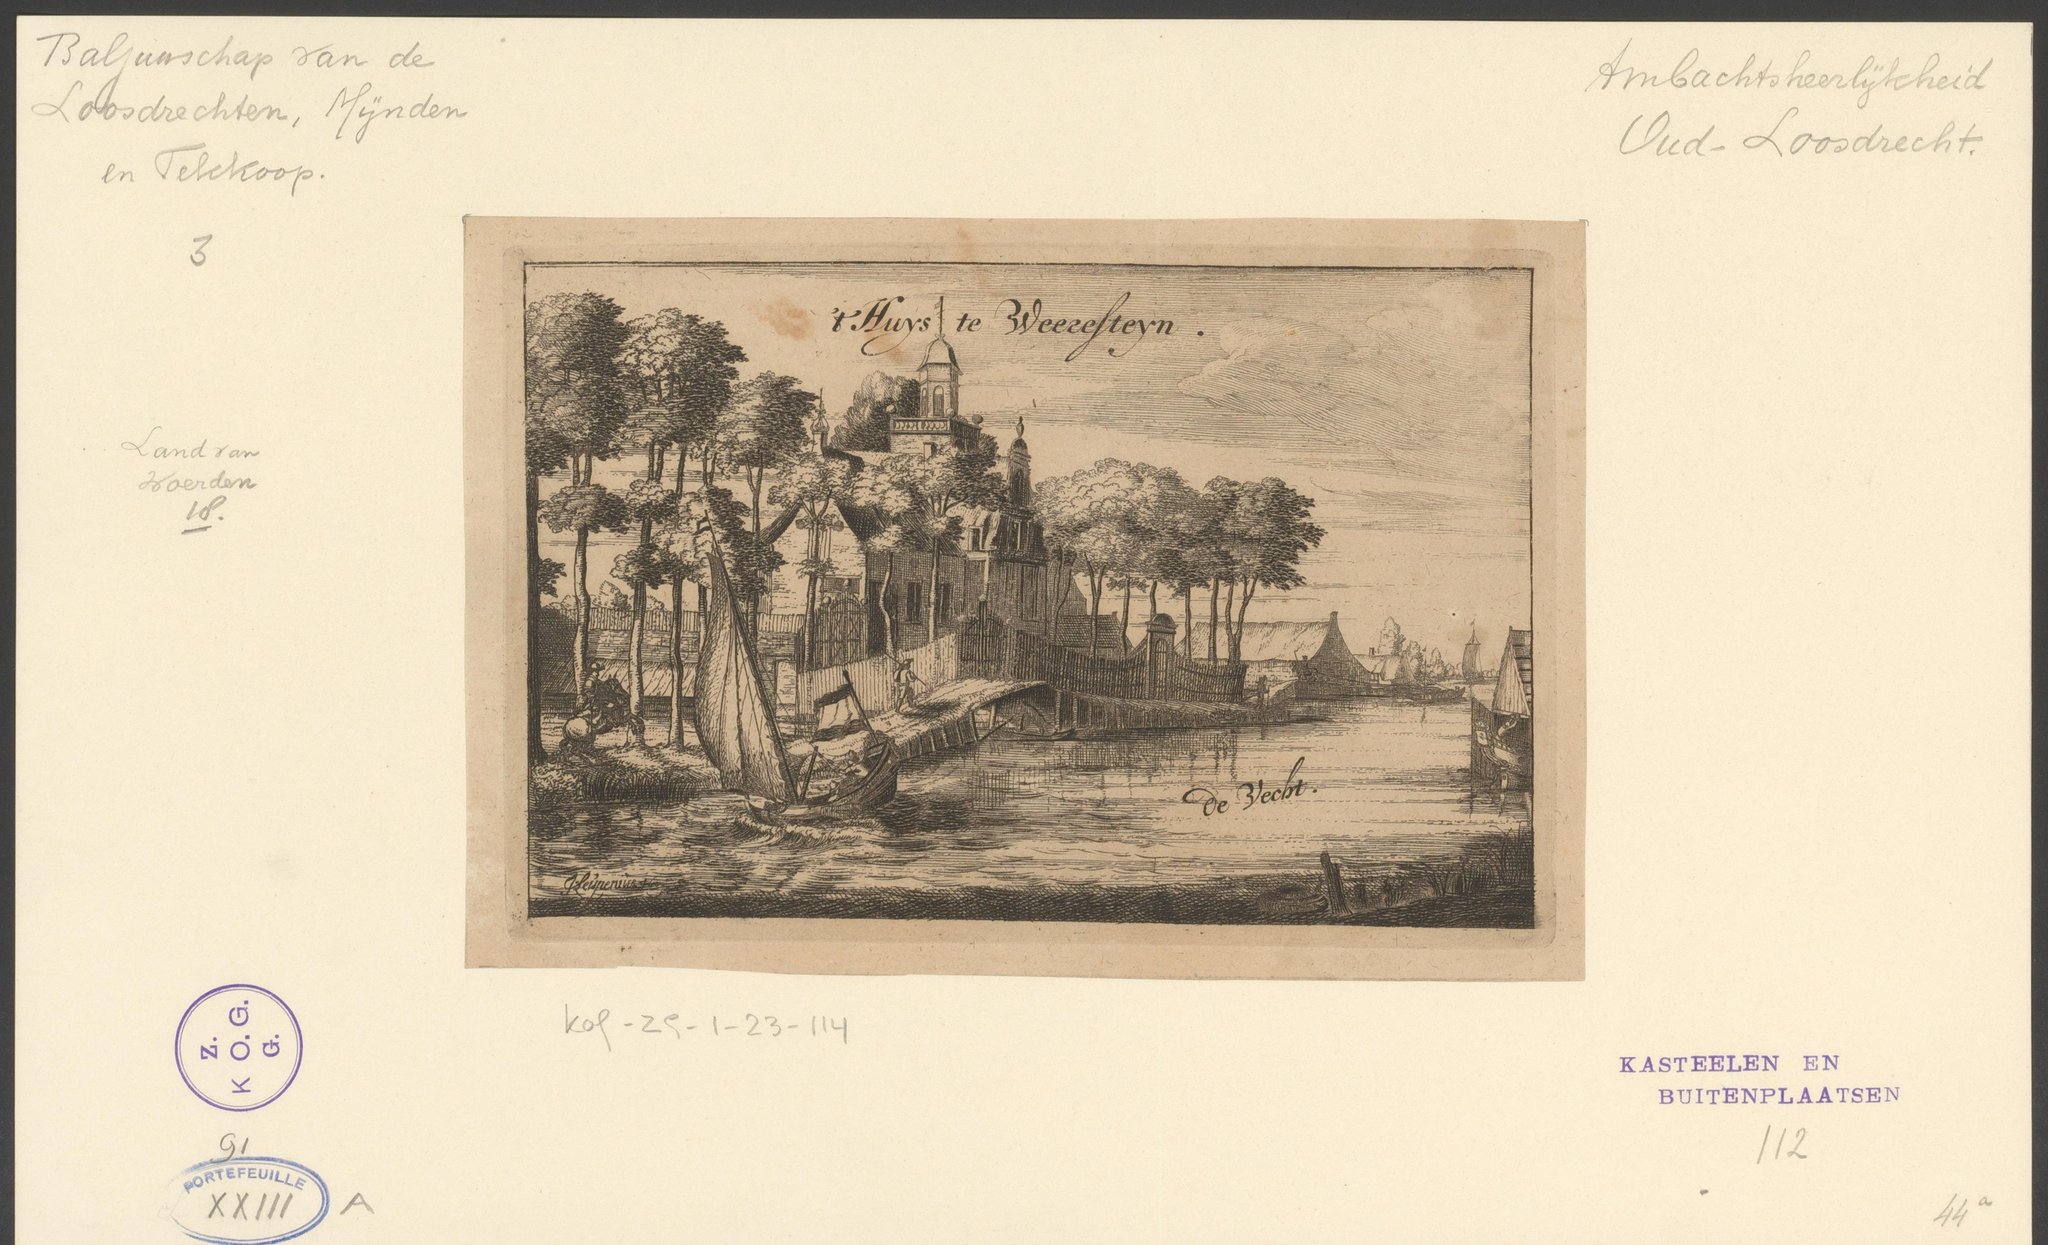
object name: print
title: 't Huys te Weeresteyn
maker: johannes leupenius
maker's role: draughtsman, painter, print maker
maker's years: 1646-1693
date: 1668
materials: paper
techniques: etching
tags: castle, river, vecht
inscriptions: stamp, collector's mark: Lugt 1641, stamp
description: Gezicht op kasteel Weerestein aan de Vecht te Nieuwersluis. De prent maakt deel uit van een zesdelige serie met voorstellingen van aan de Vecht en Amstel gelegen kastelen en herbergen. Onderwerpsrubrieken binnen de Atlas Zeden en Gewoonten: Zeden en Gewoonten in Engeren Zin, De Woning. Kastelen en buitenplaatsen. Holland (vervolg.)